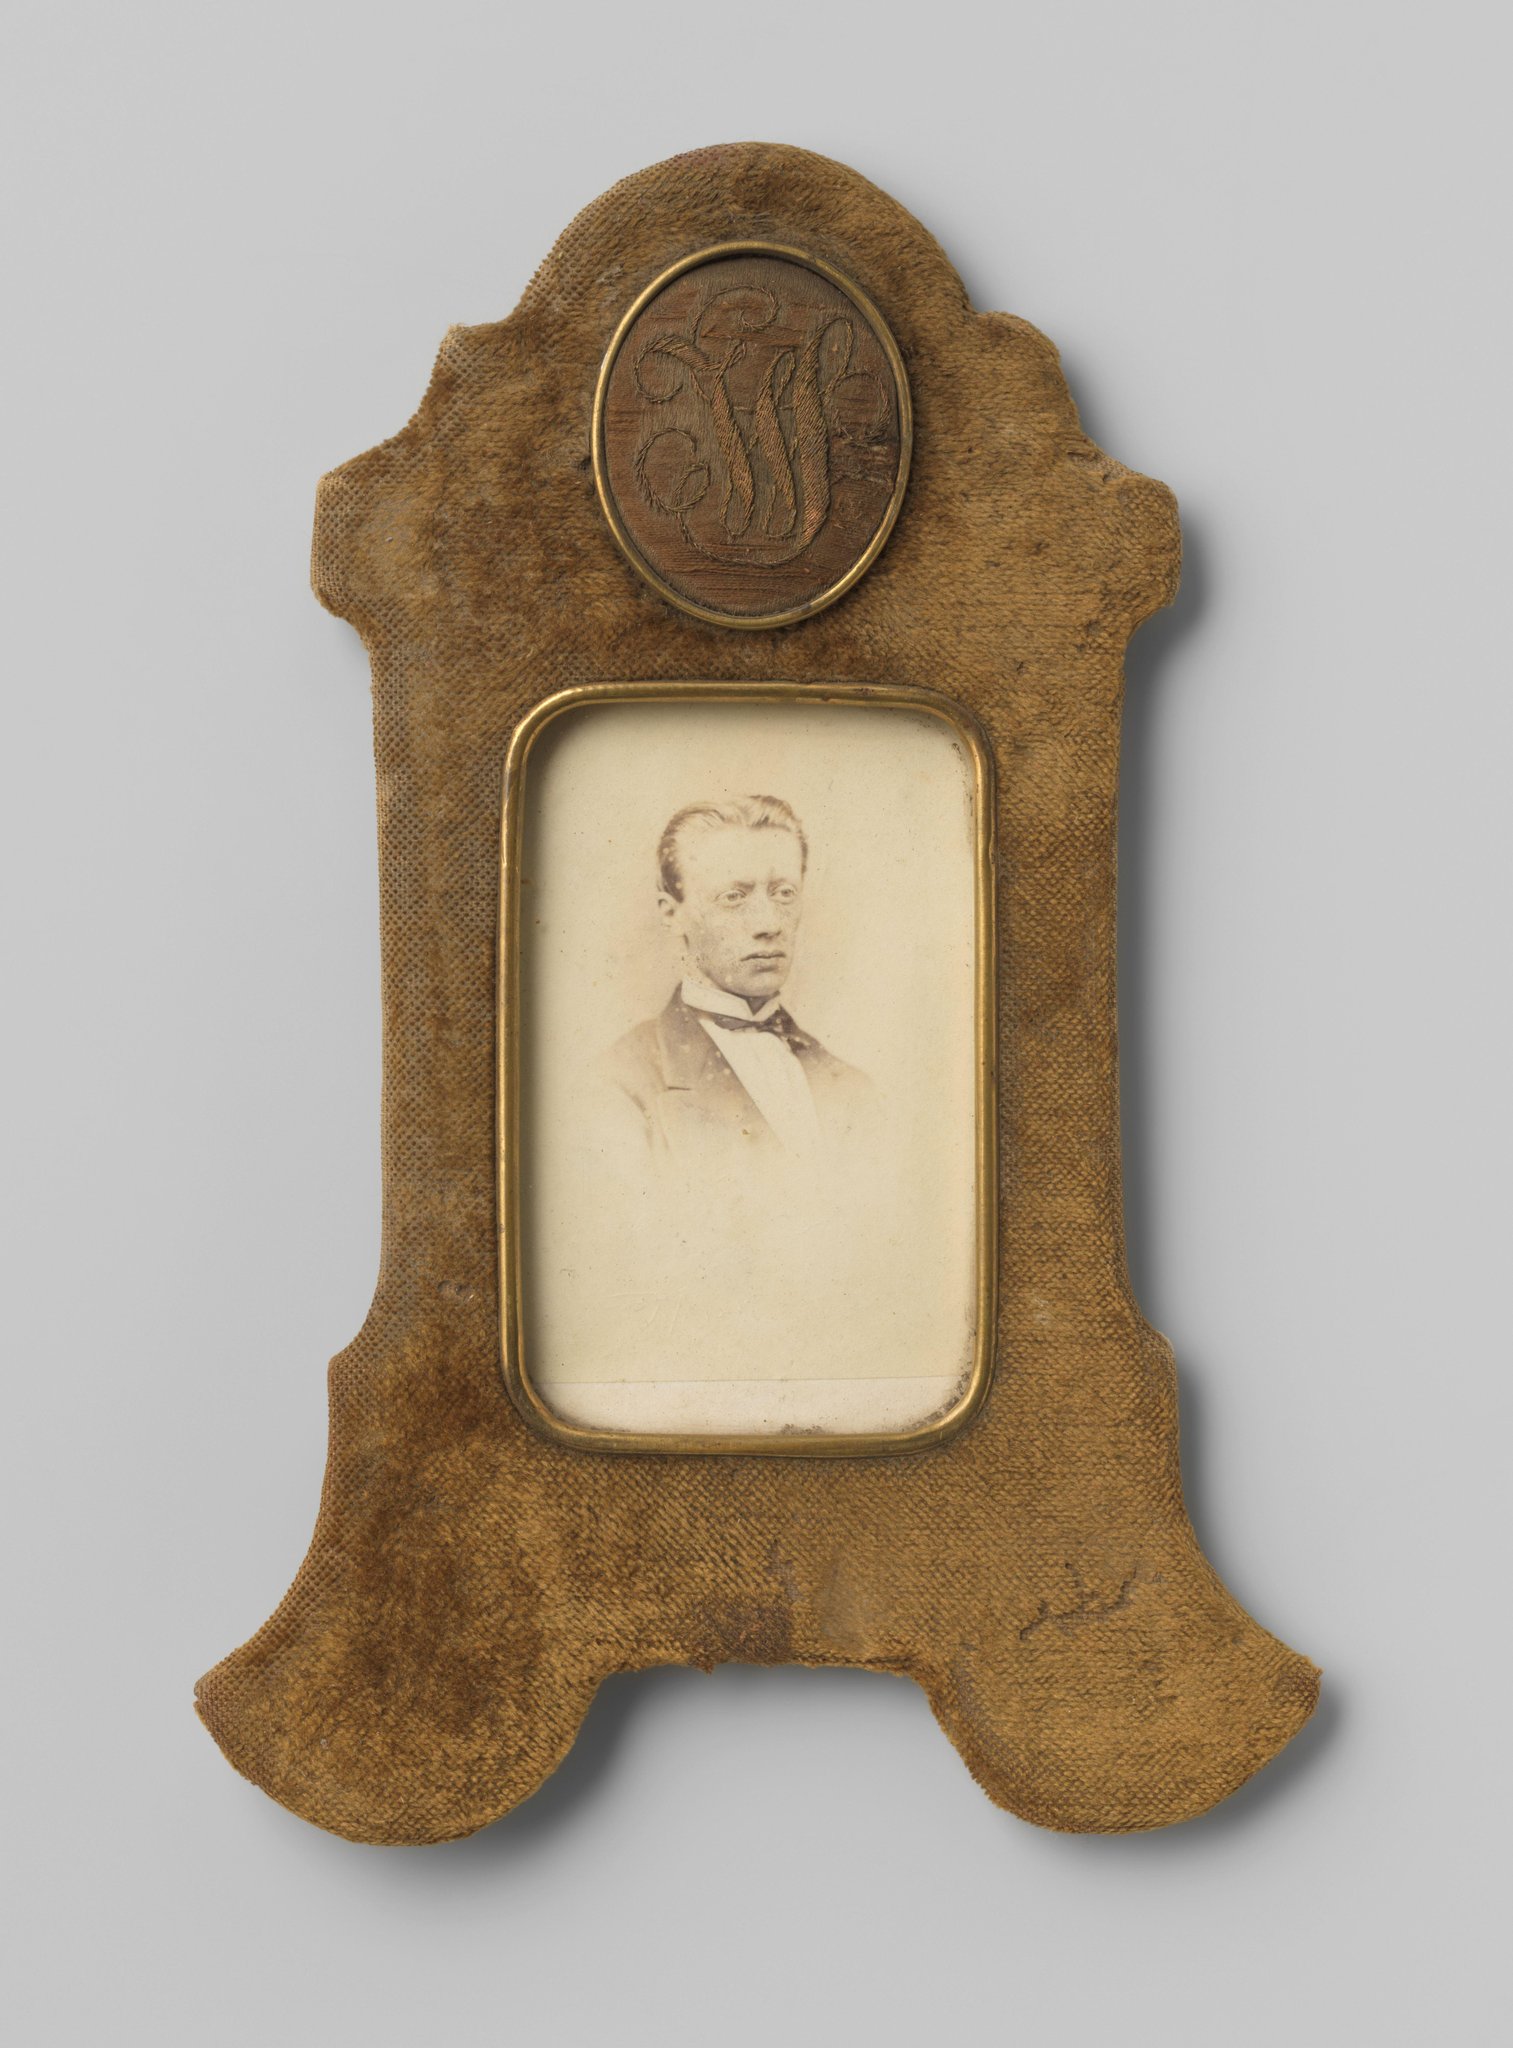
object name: frame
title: Portret van een onbekende man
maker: Anonymous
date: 1880-1900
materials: cardboard, glass, metal, paper, textile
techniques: albumen print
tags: adult man, anonymous historical person portrayed